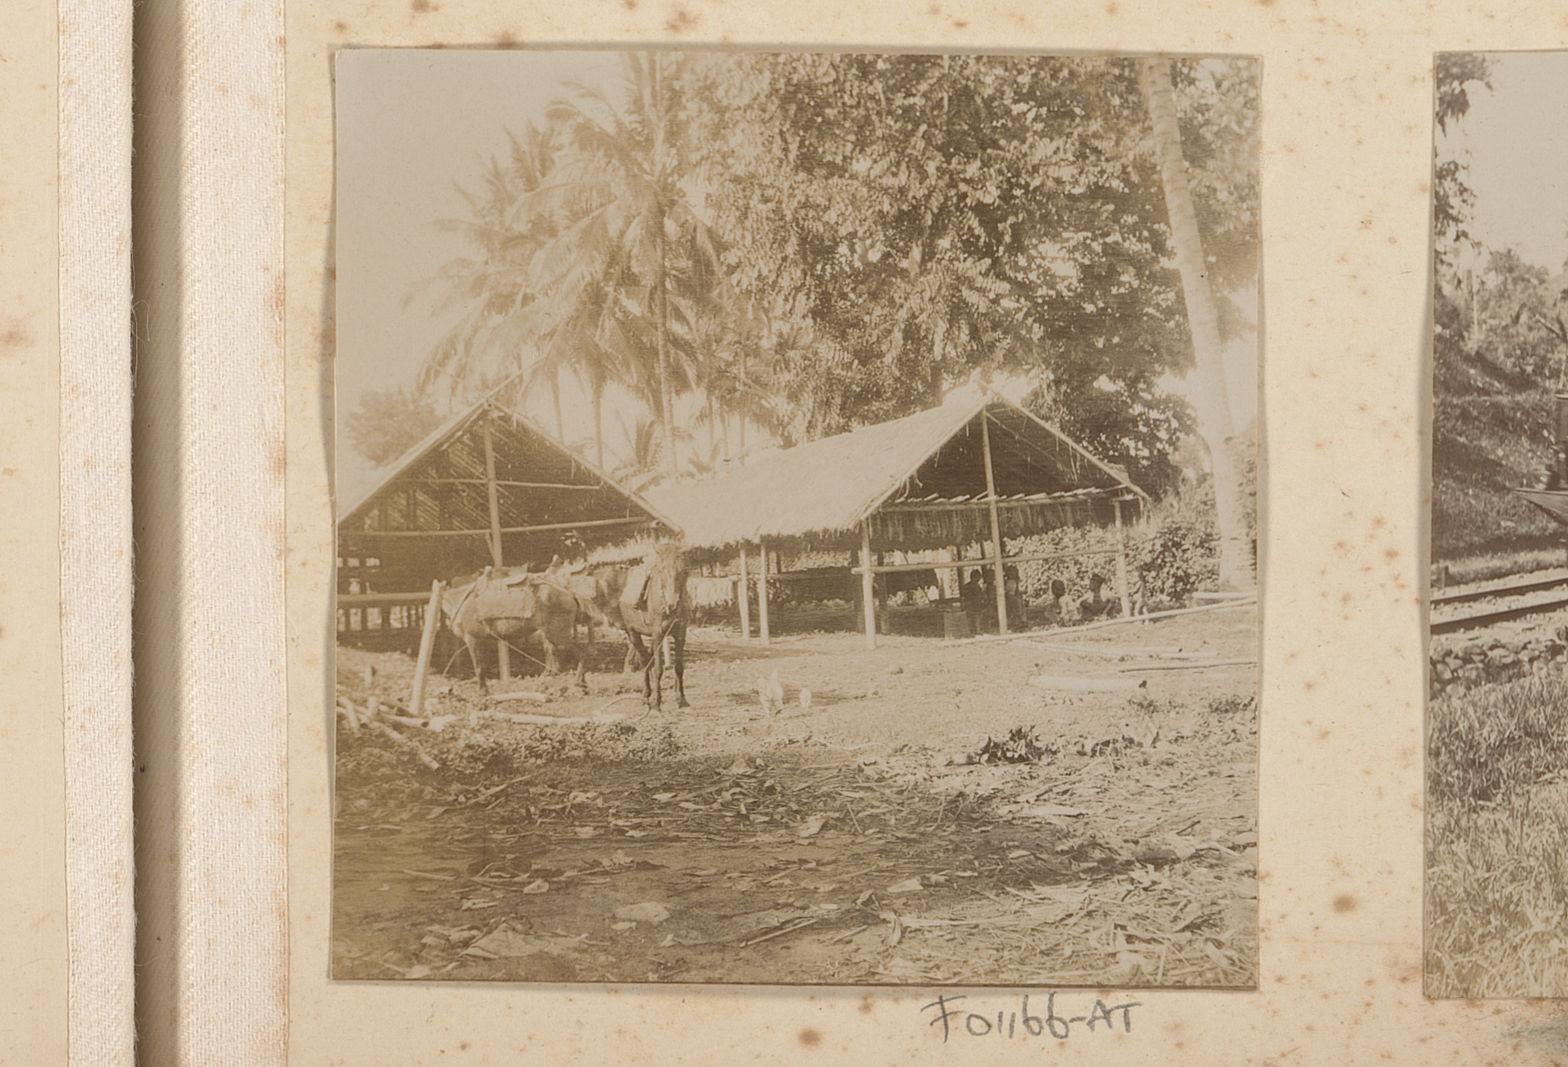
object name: album leaf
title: Paarden voor schuren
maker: Anonymous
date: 1890-1910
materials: photographic support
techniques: gelatin silver print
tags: annexes and outbuildings; fencing; gate, horse, dutch east indies, the